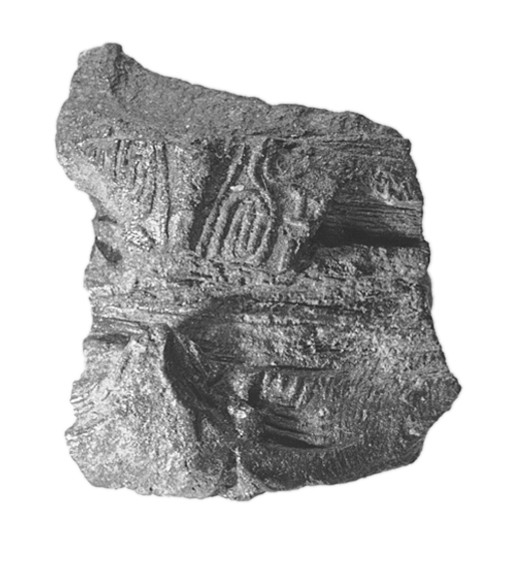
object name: sealing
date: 1981-1640 BCE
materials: mud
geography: egypt